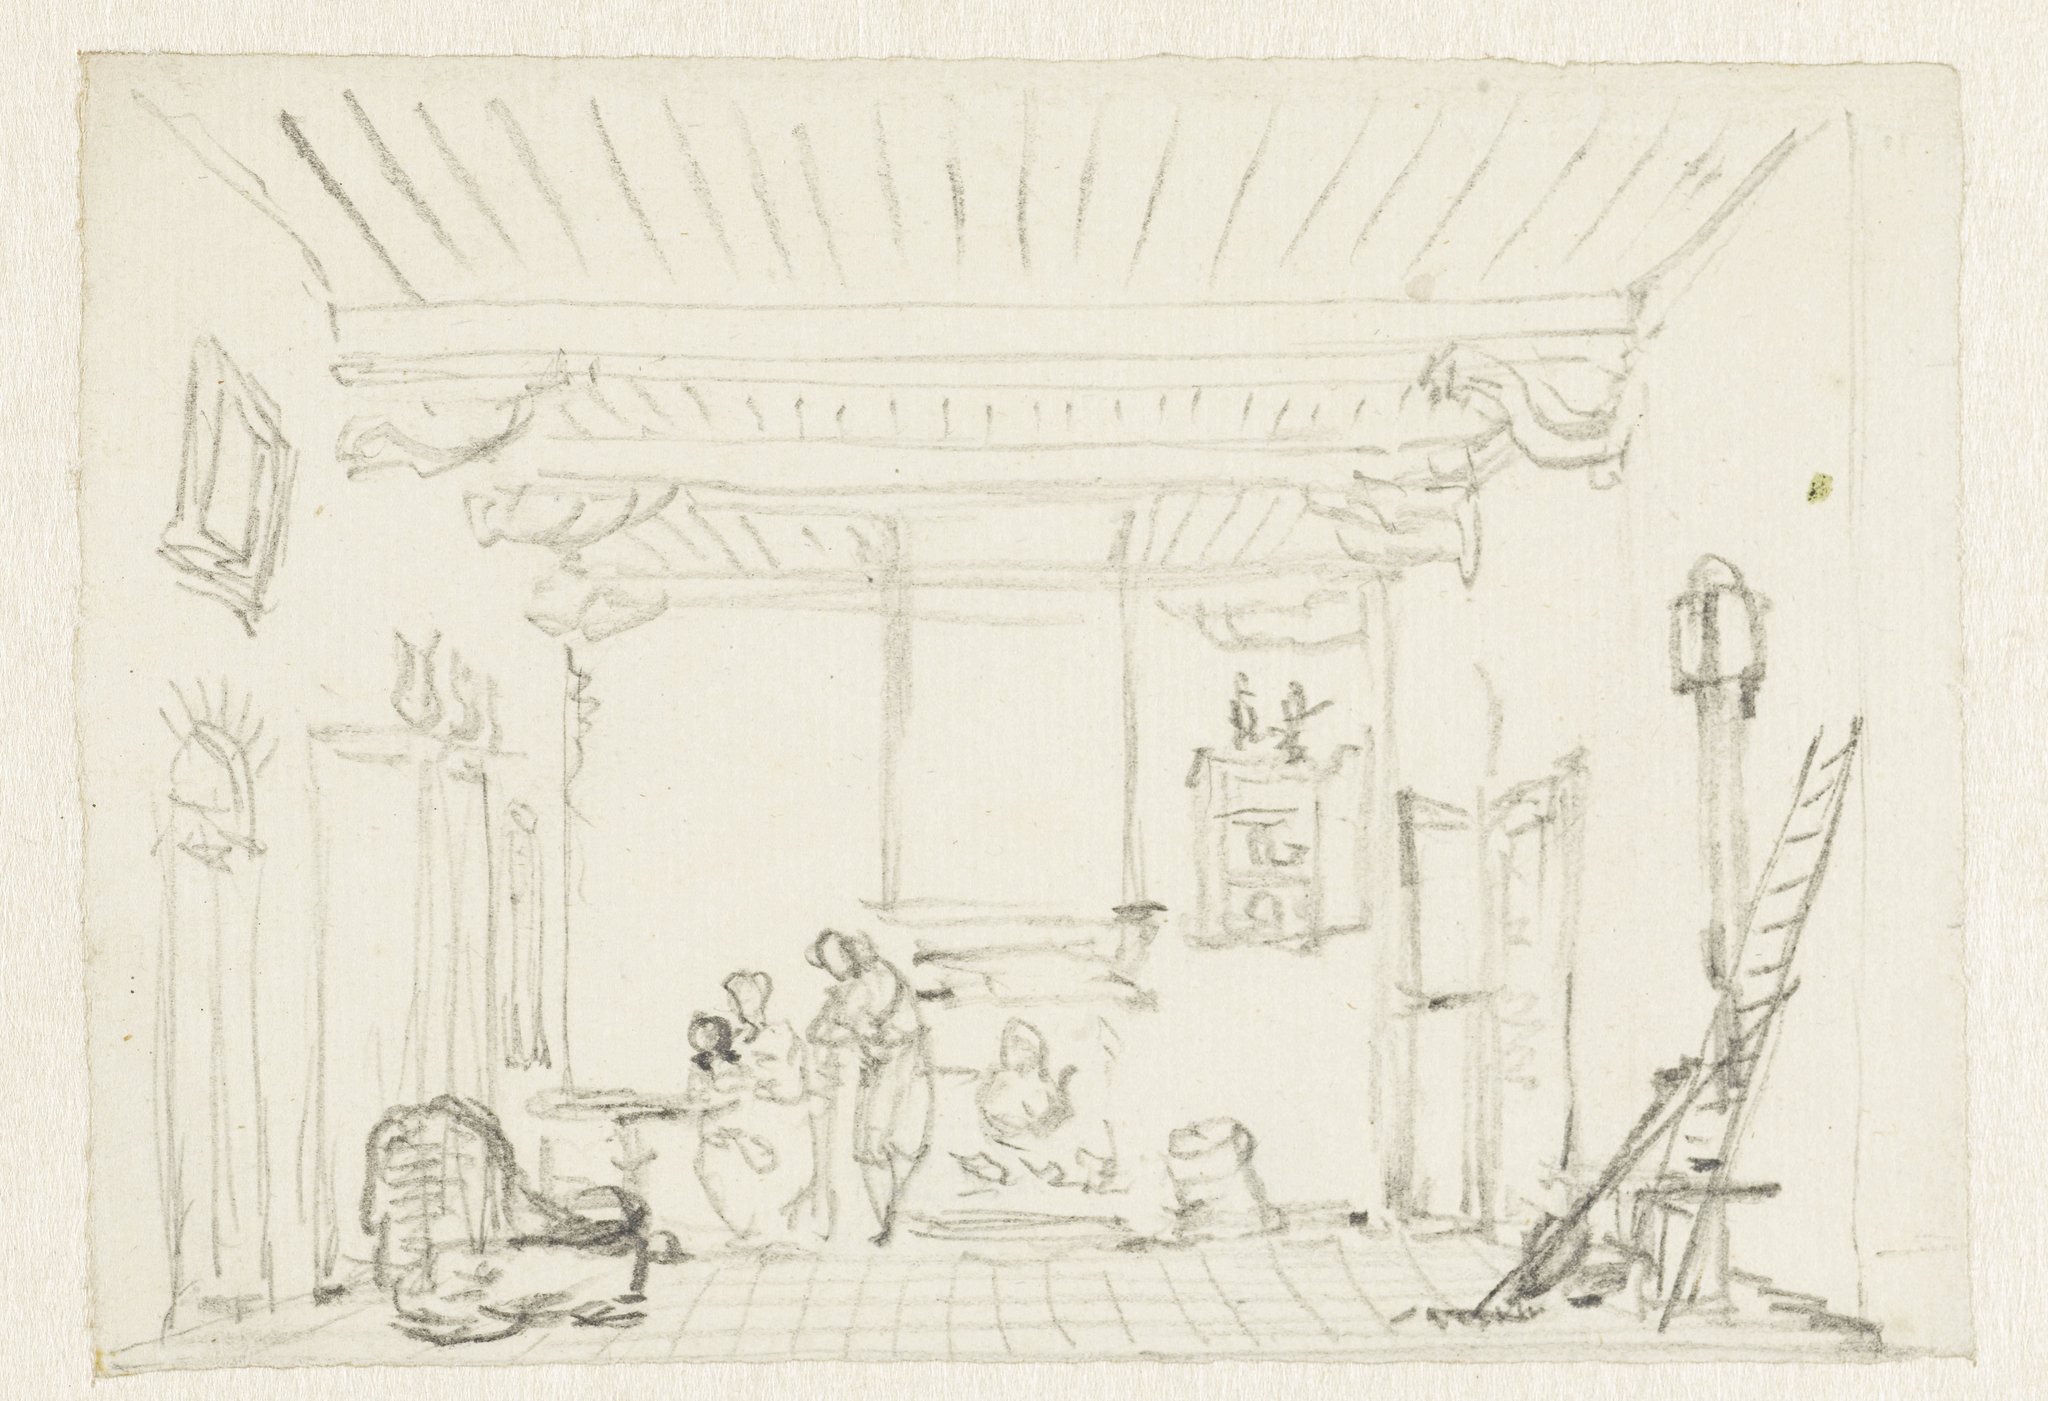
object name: drawing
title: Interieur met ouders met kind bij haard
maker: pieter bartholomeusz. barbiers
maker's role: draughtsman, print maker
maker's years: 1772-1837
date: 1782-1837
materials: graphite, paper